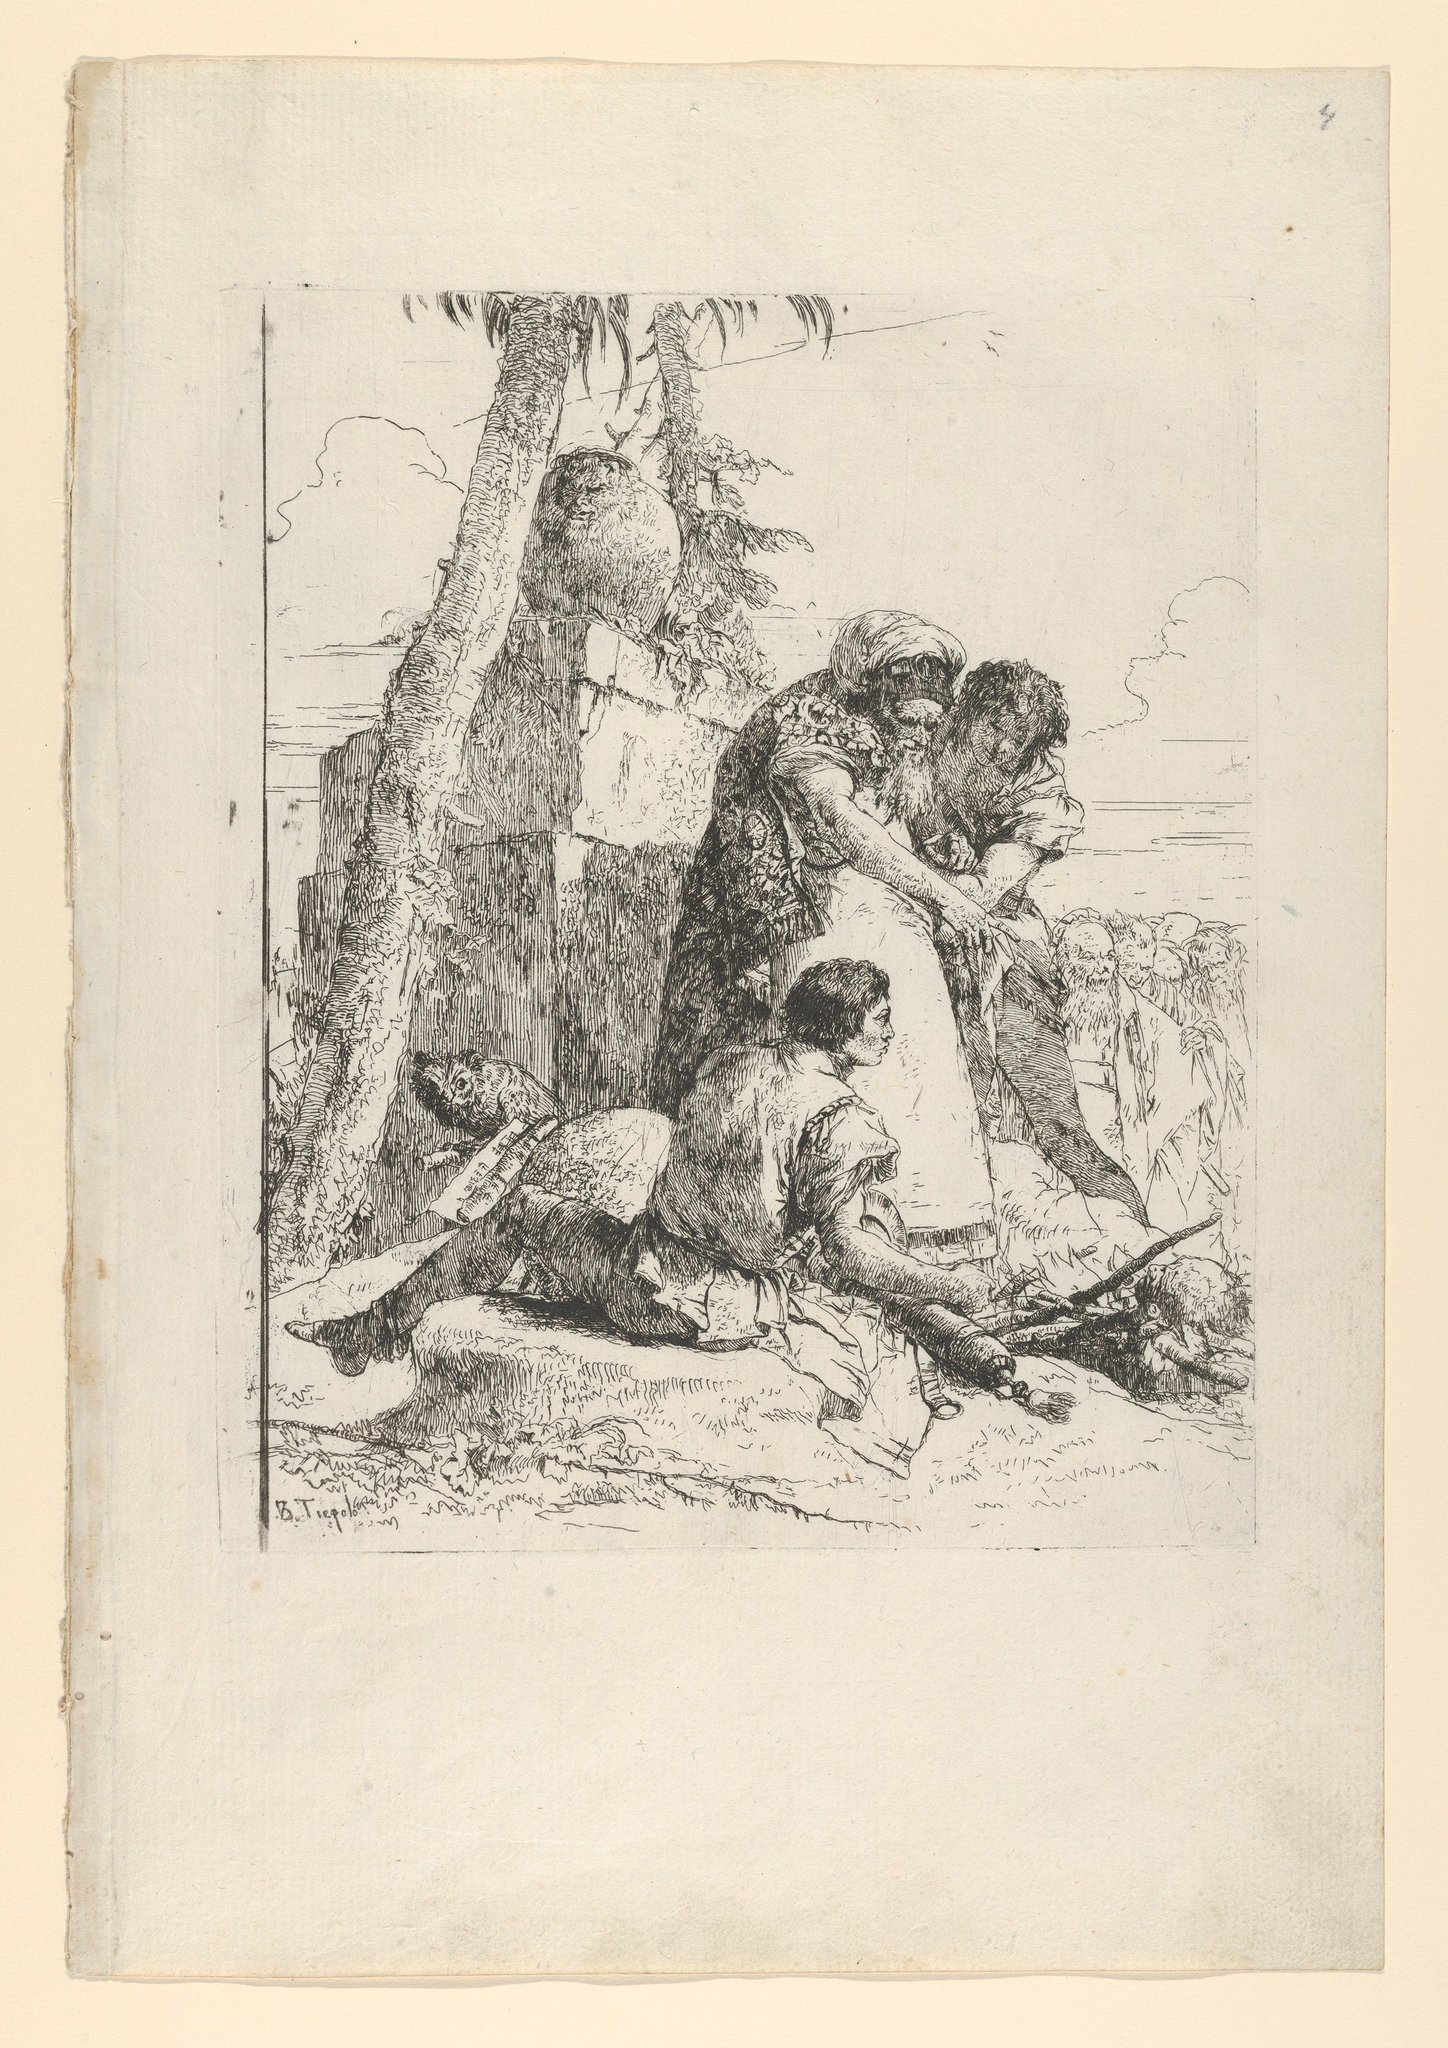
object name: print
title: Magician pointing out a burning head to two youths, from the Scherzi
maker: giovanni battista tiepolo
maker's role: artist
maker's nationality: italian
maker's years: 1696-1770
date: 1743-1750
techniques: etching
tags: heads,men,women,magicians